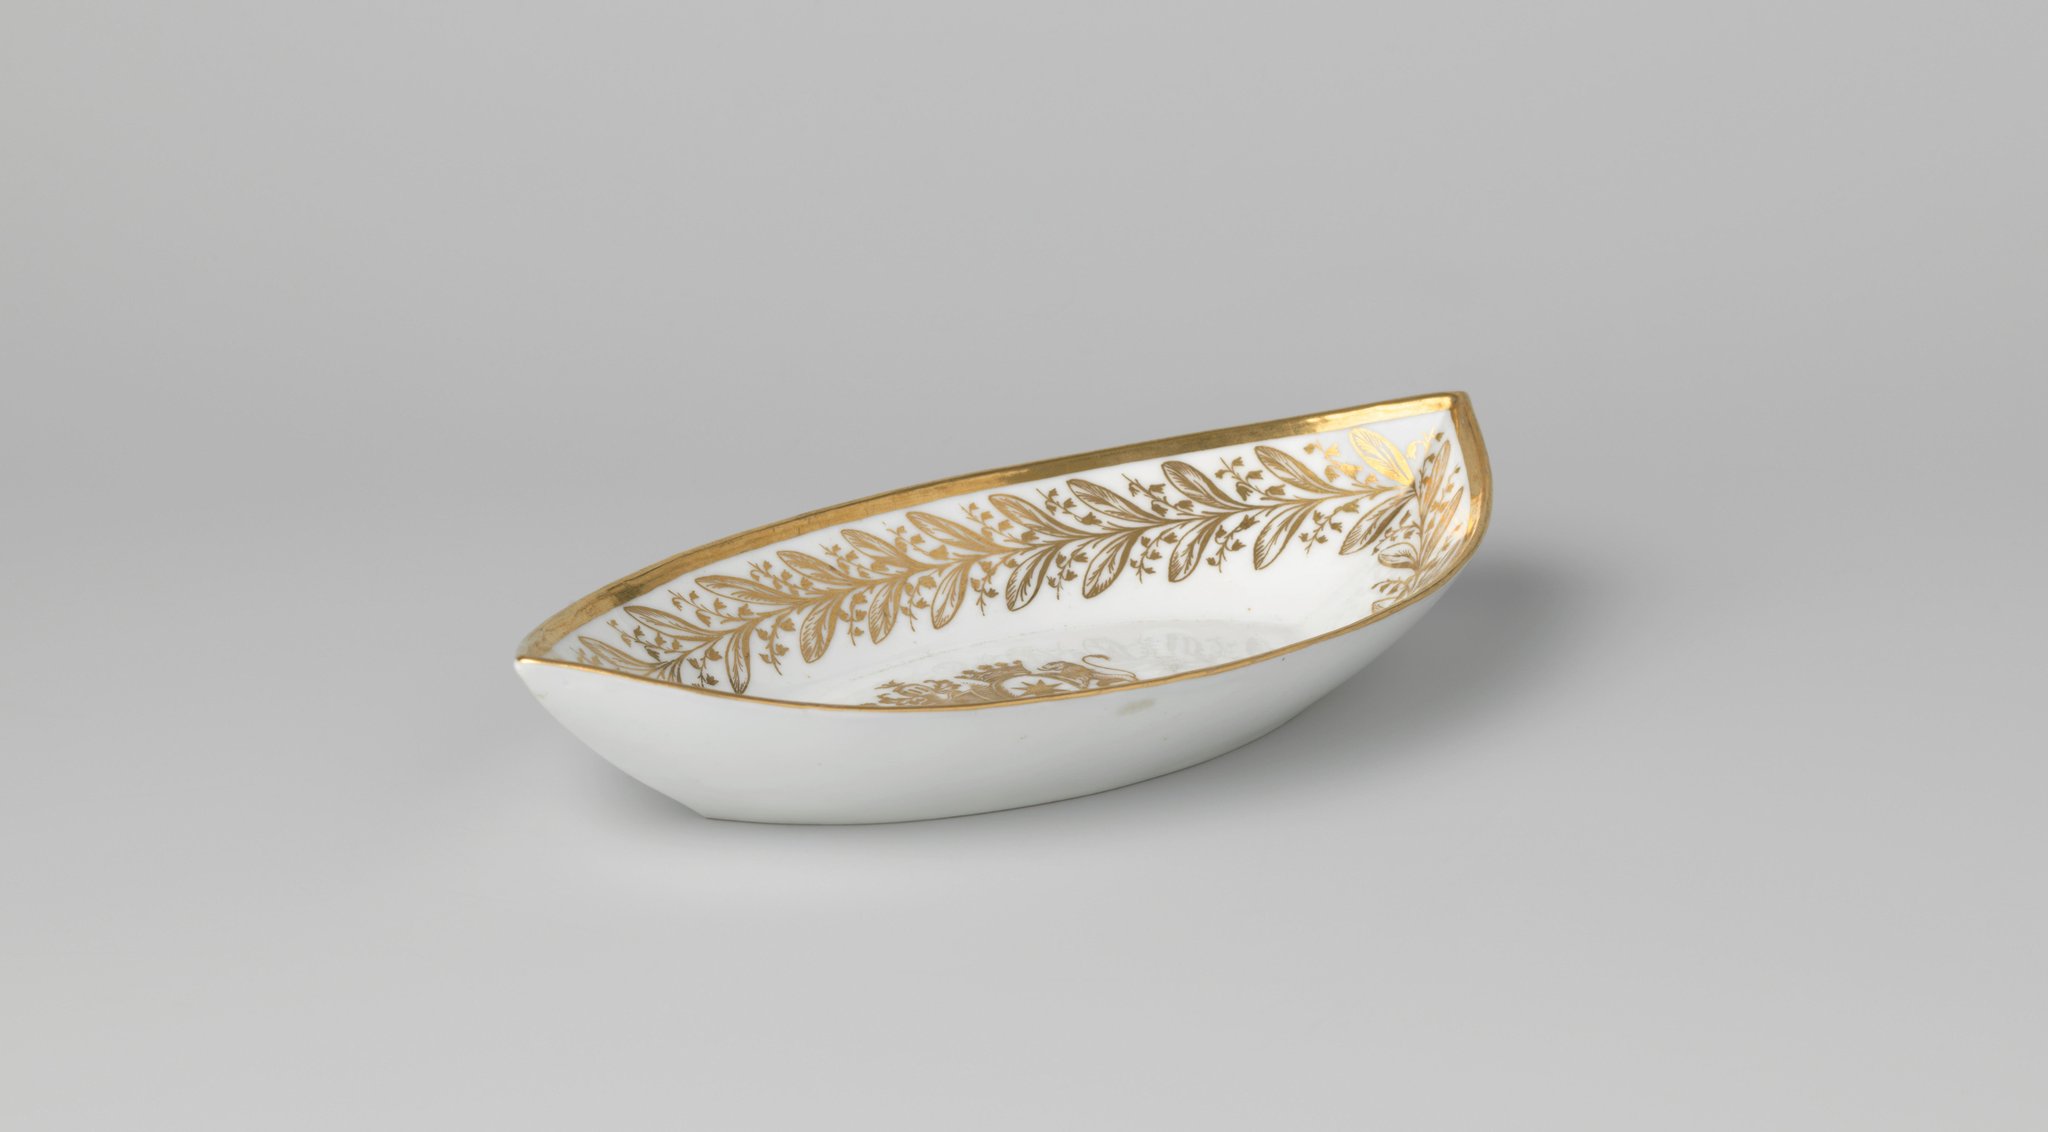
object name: dish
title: Dish with the coat of arms of Hendrik Peter Godfried Quack and Isabella Gertraud von Carnap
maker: Anonymous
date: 1790-1800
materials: glaze, gold, paint, porcelain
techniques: firing, forming, gilding, turning, vitrification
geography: paris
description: Schaal van porselein, waarbij de zijkanten spits toelopen. Beschilderd op het glazuur met goud. Op het plat het alliantiewapen van Hendrik Peter Godfried Quack en Isabella Gertraud von Carnap. De binnenwand met een bloemrank en een gouden band op de rand. Geen voetring.